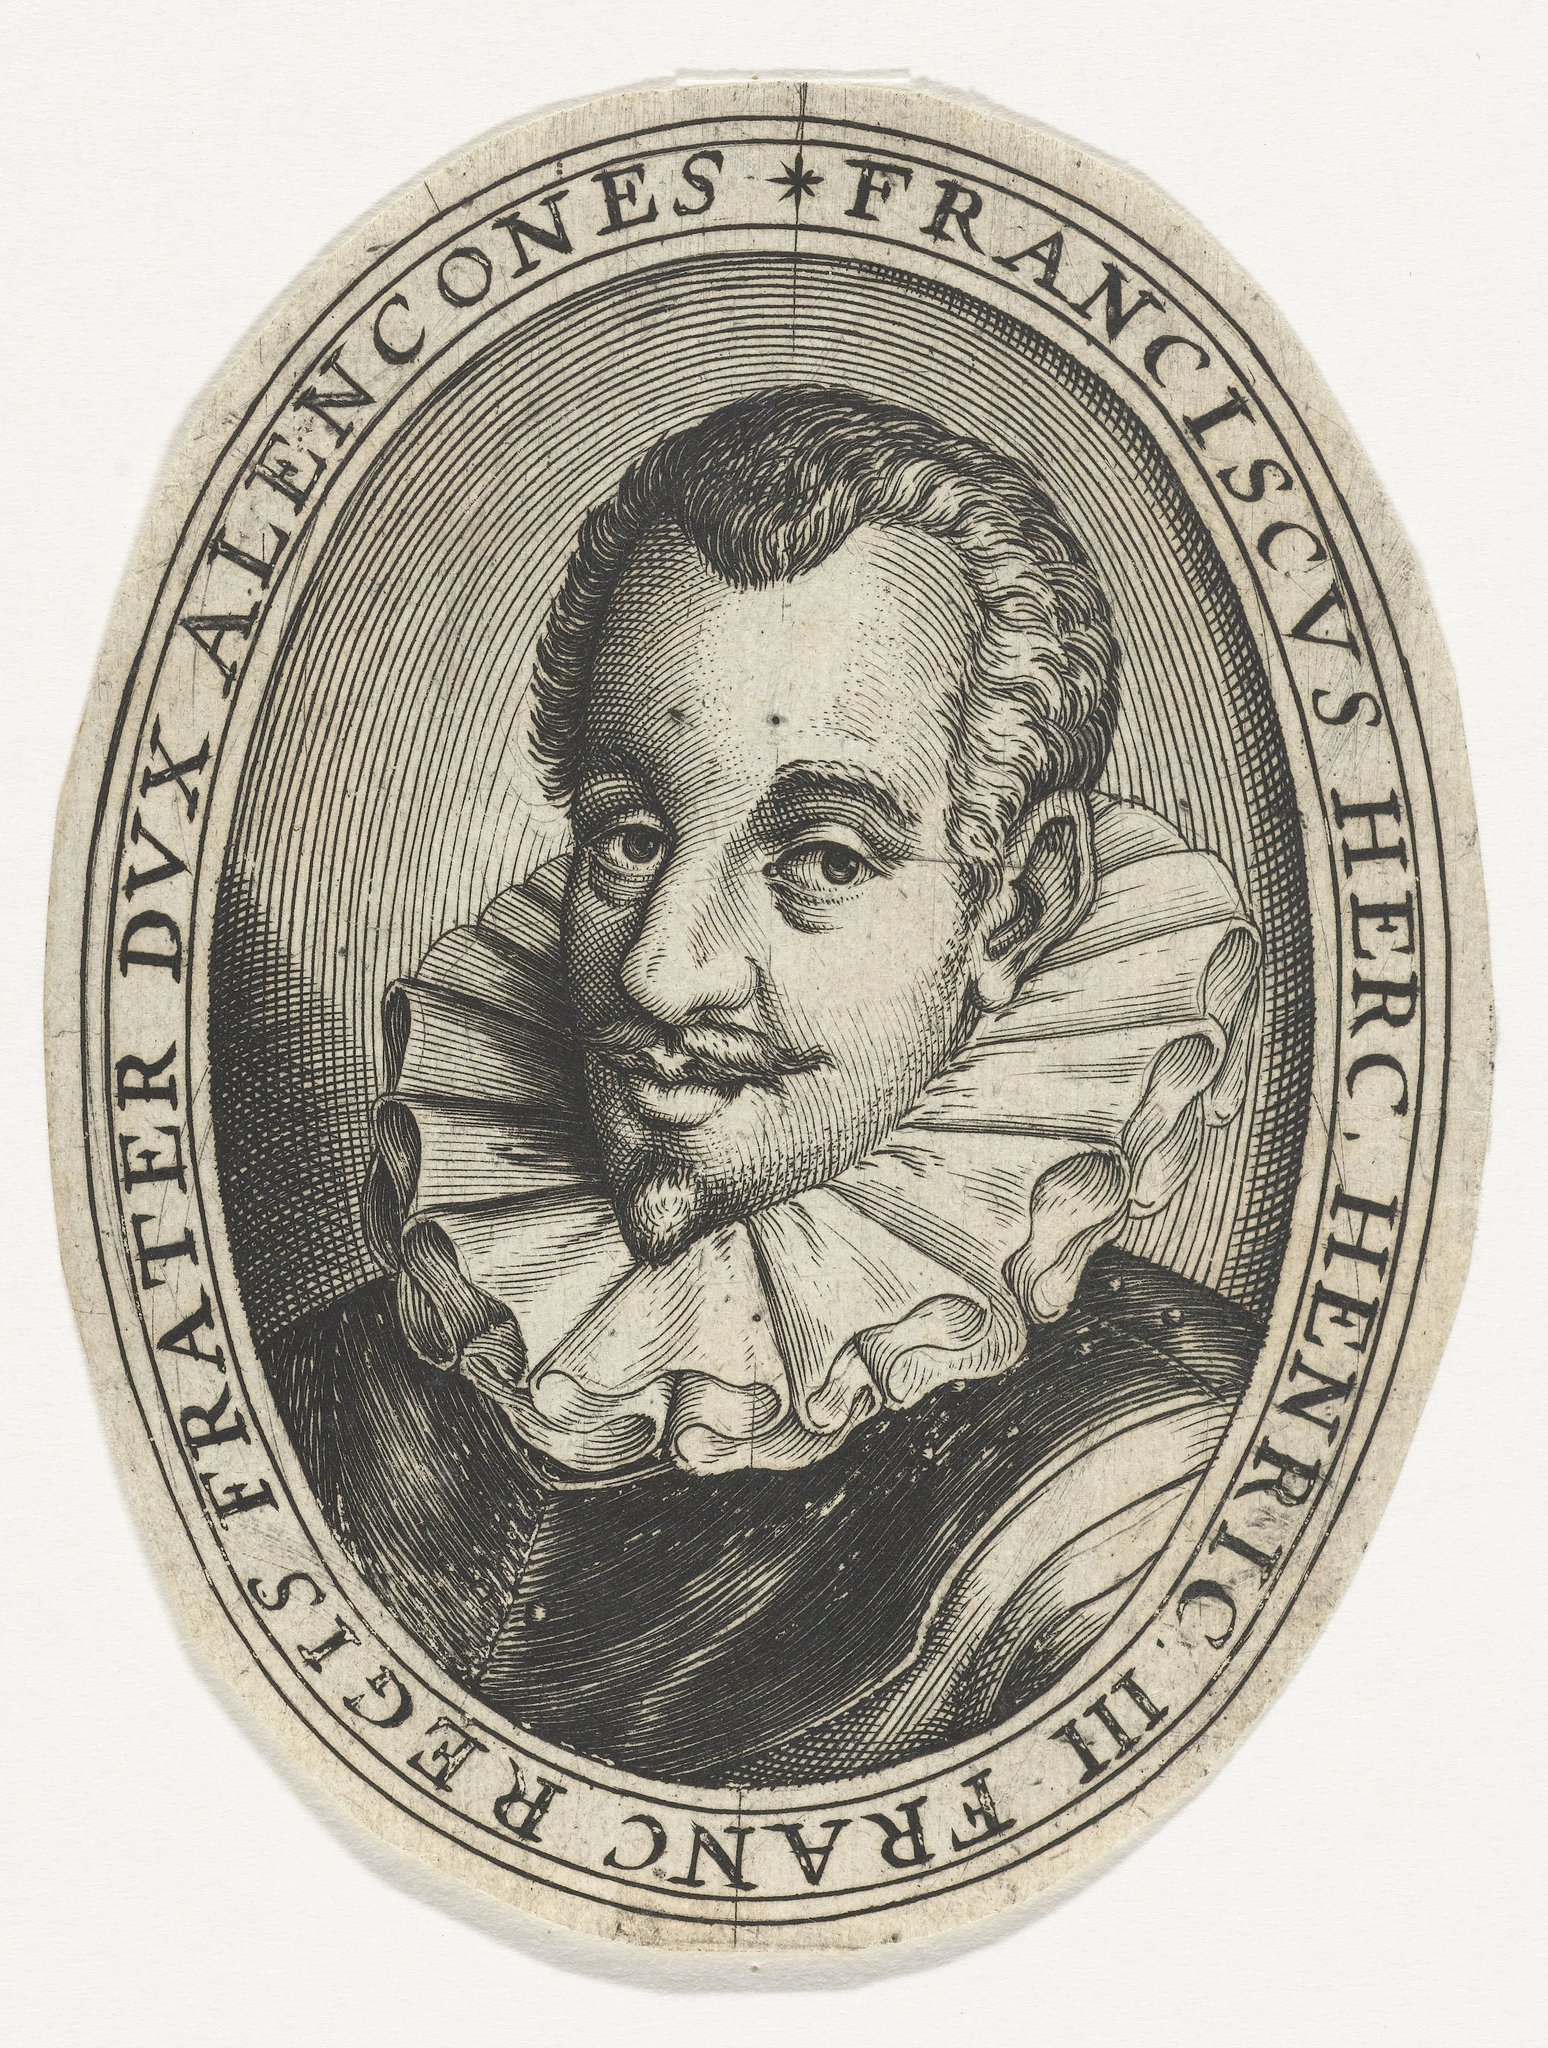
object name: print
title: Portret van Frans Hercules van Valois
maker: lambert cornelisz.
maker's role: draughtsman, print maker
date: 1593-1612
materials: paper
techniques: engraving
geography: amsterdam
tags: ruler, sovereign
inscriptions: collector's mark: Lugt 2228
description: Portret van Frans Hercules van Valois hertog van Alençon, in ovaal met randschrift.